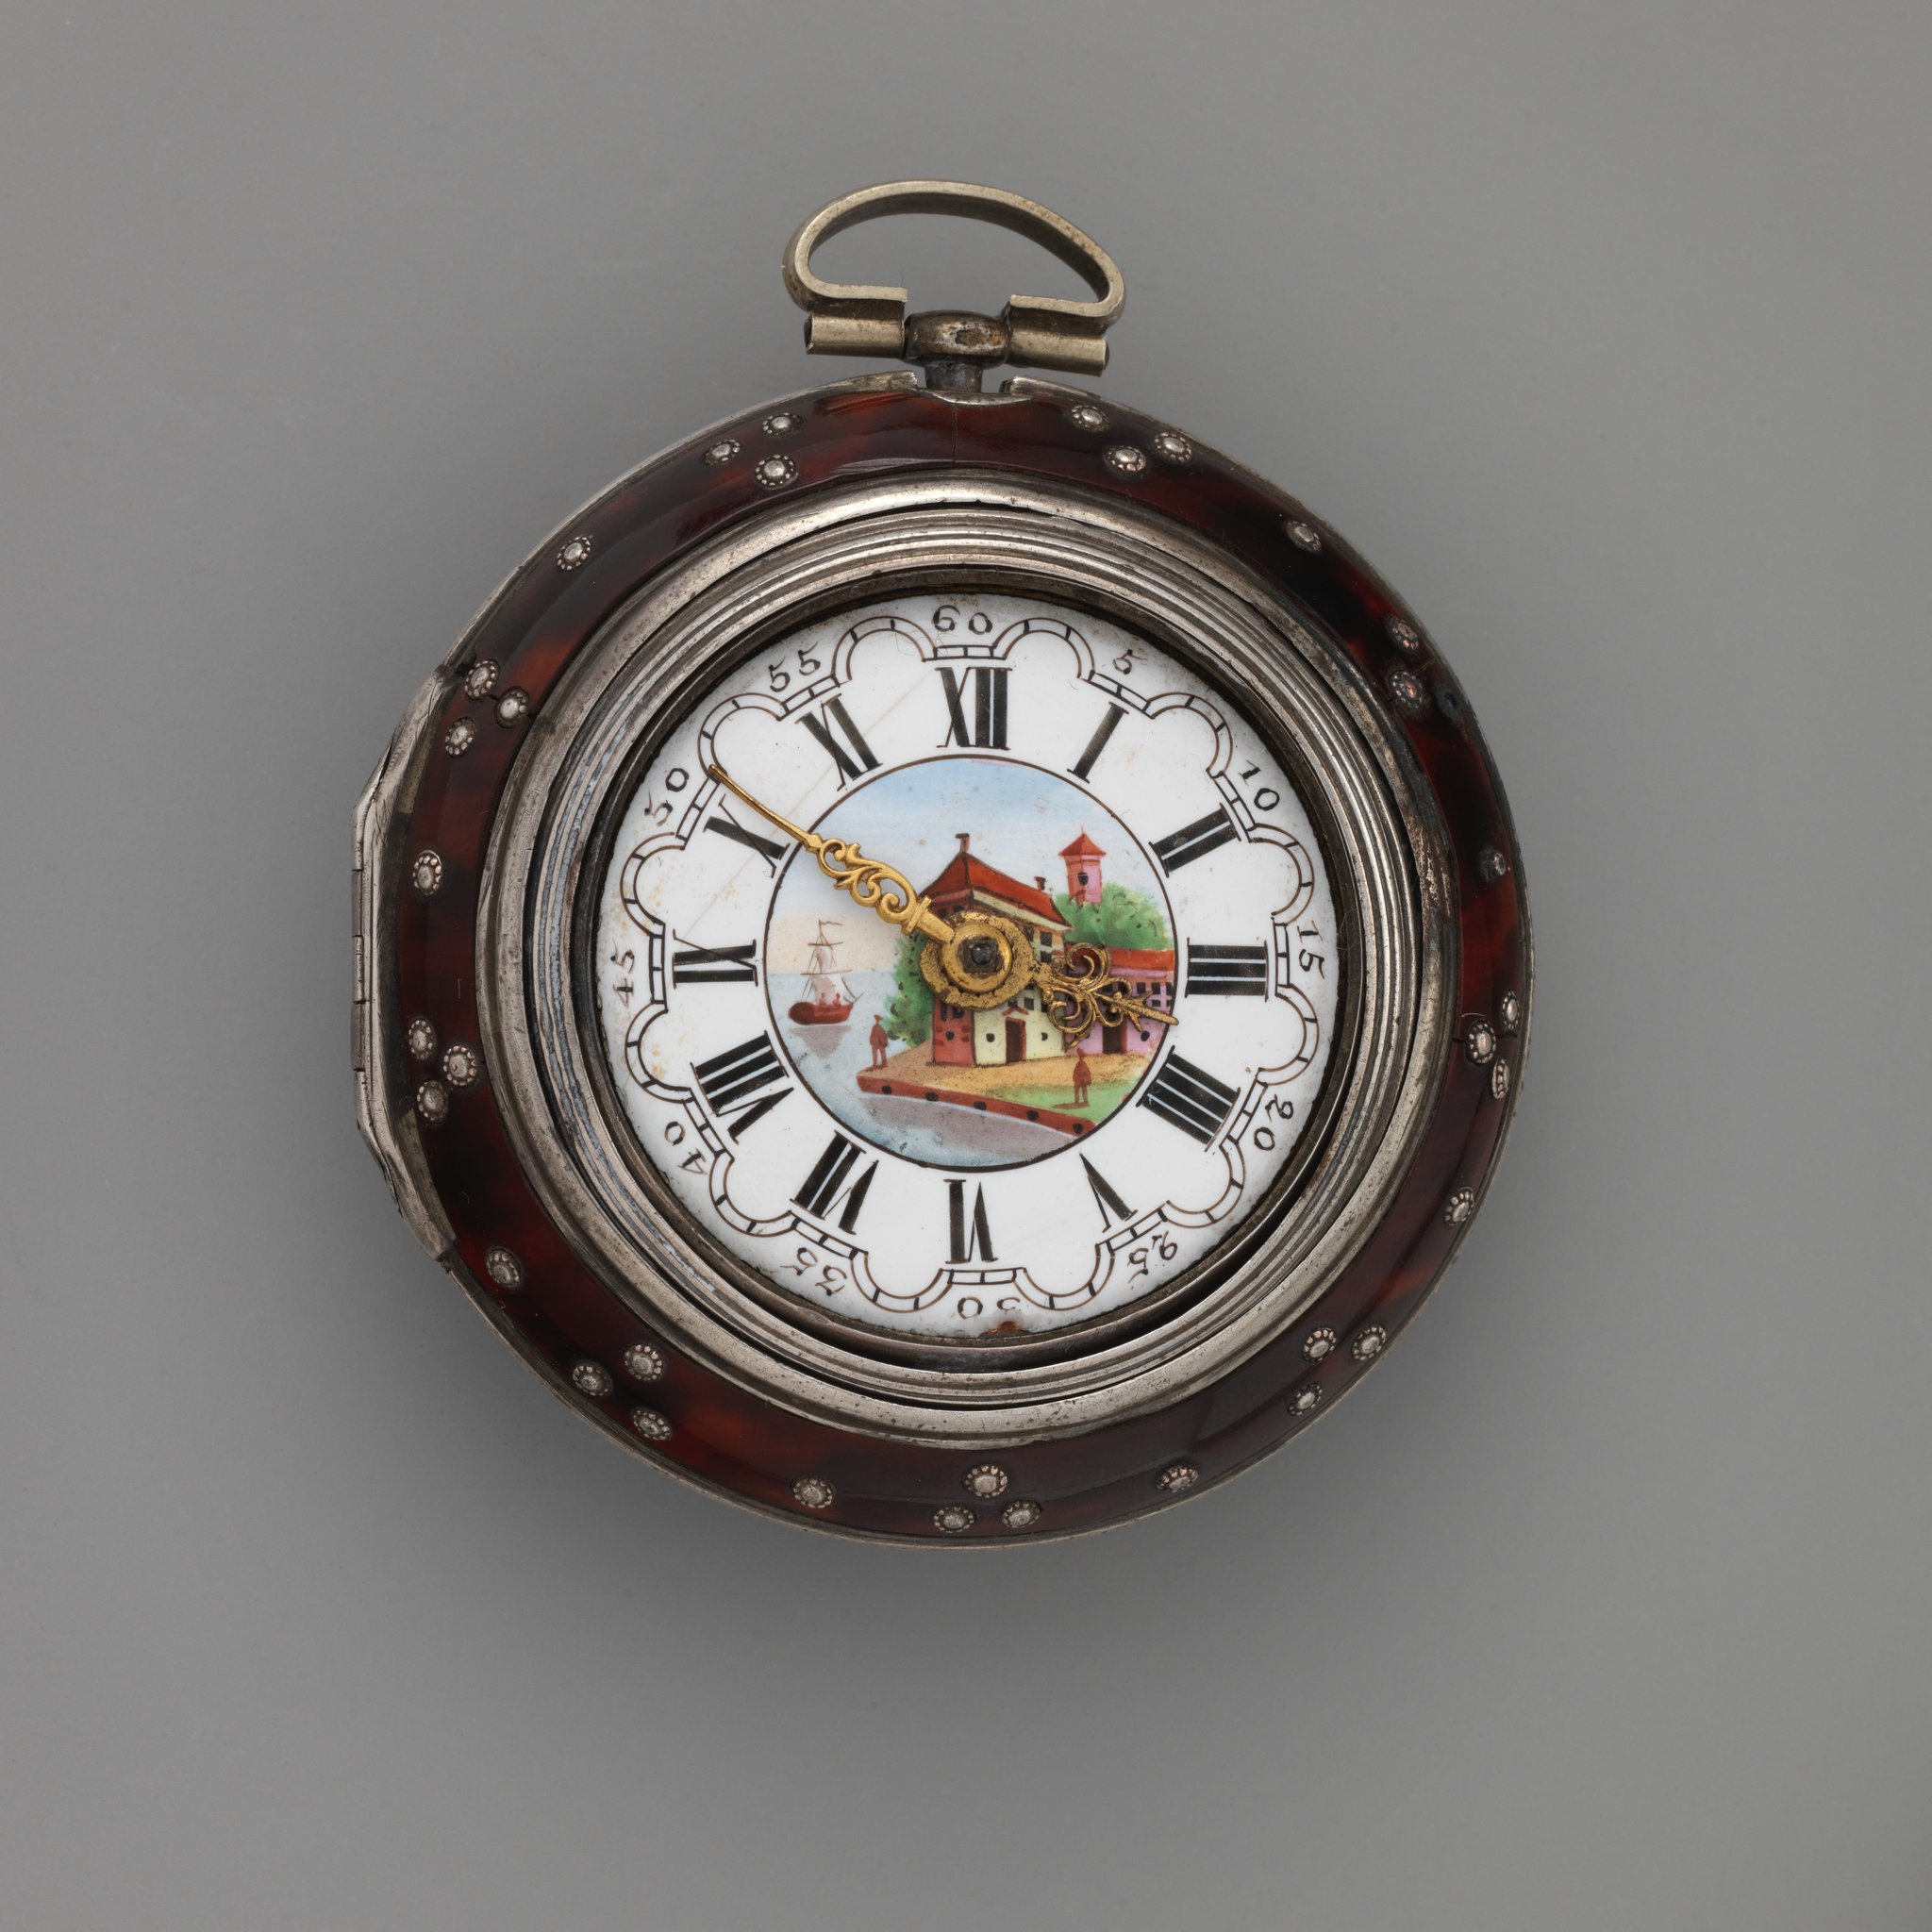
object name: watch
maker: w. welldon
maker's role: maker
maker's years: 1750-1850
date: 1790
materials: enamel, silver, shell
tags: houses,ships